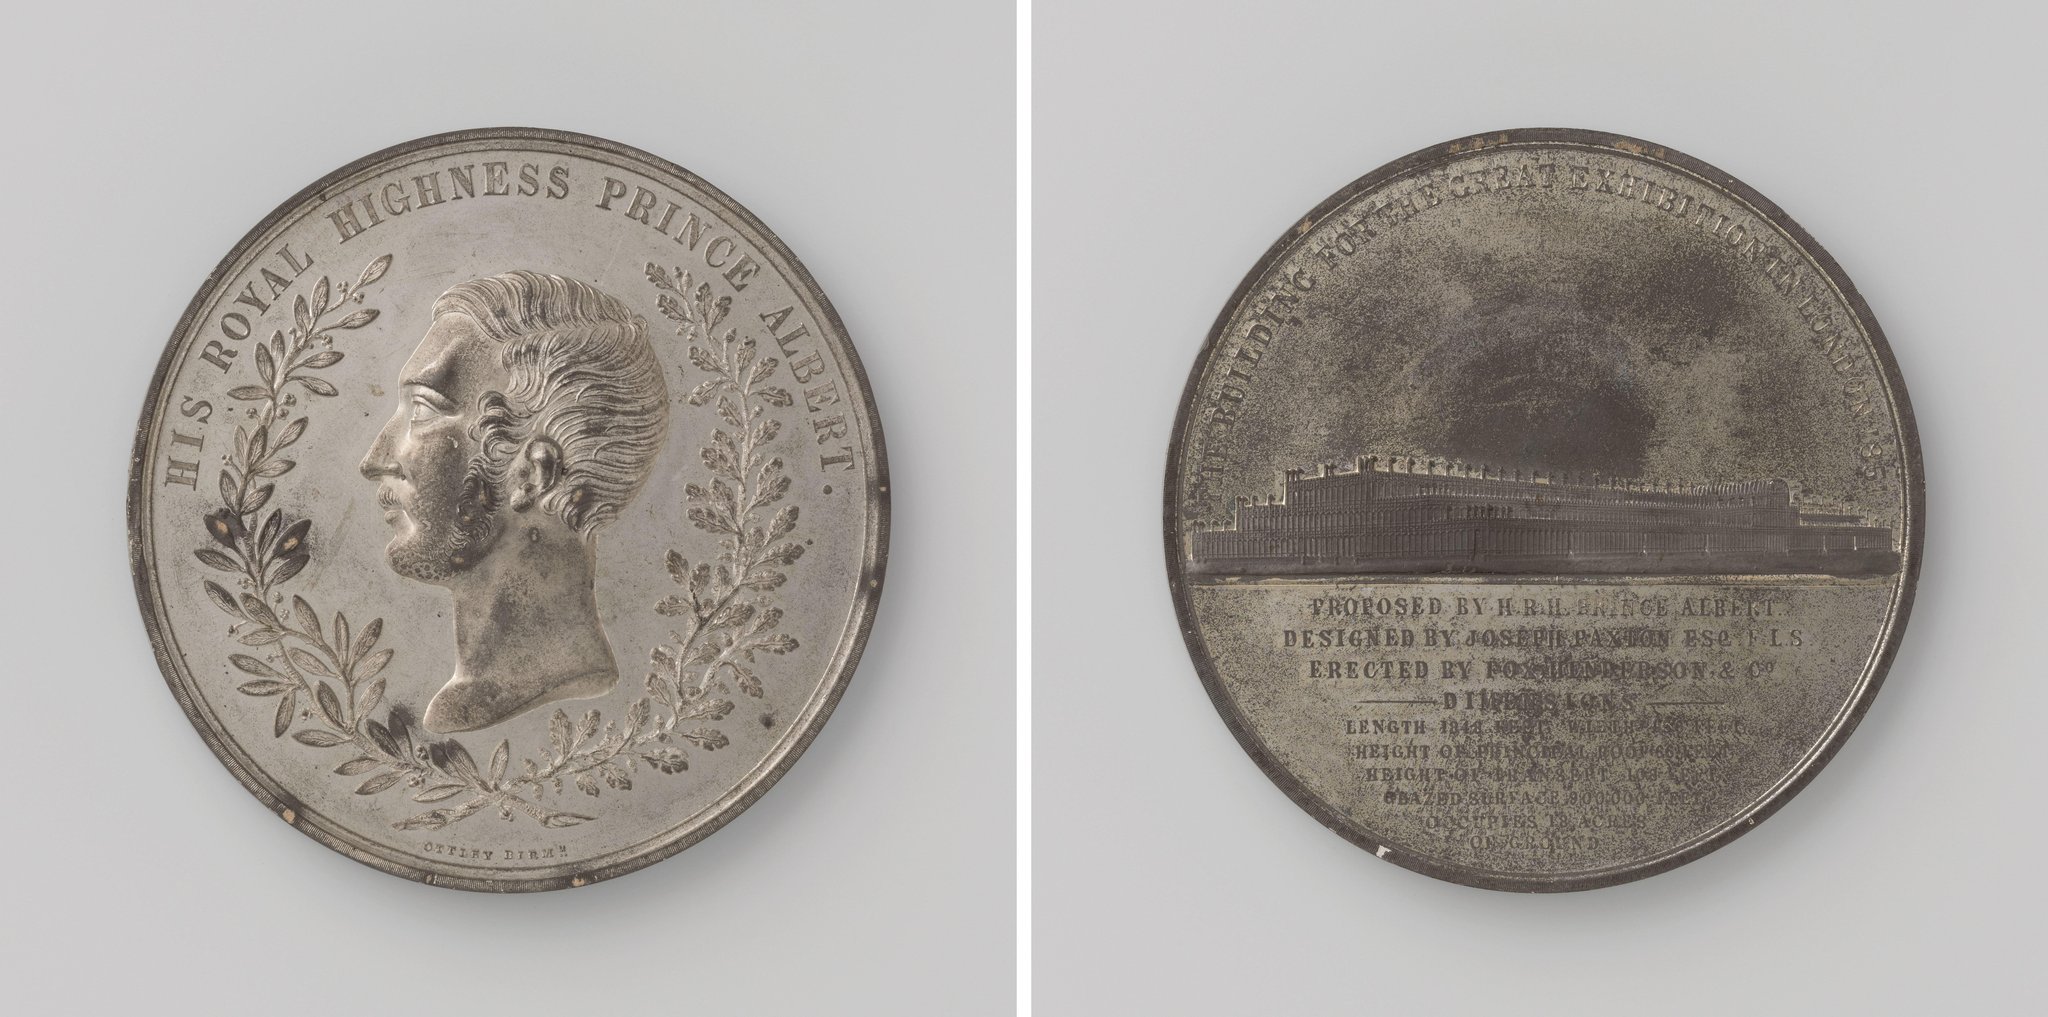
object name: history medal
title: Bouw van het Crystal Palace voor de internationale tentoonstelling van industrie te Londen, ter ere van Albert, prins van Saksen-Coburg-Gotha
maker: john ottley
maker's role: medailleur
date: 1851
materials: alloy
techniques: striking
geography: birmingham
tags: albert (prins van saksen-coburg en gotha)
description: Penning. Voorzijde: borststuk man binnen tot krans samengebonden eike- en lauwertak en omschrift. Keerzijde: paleis binnen omschrift; afsnede: opschrift.